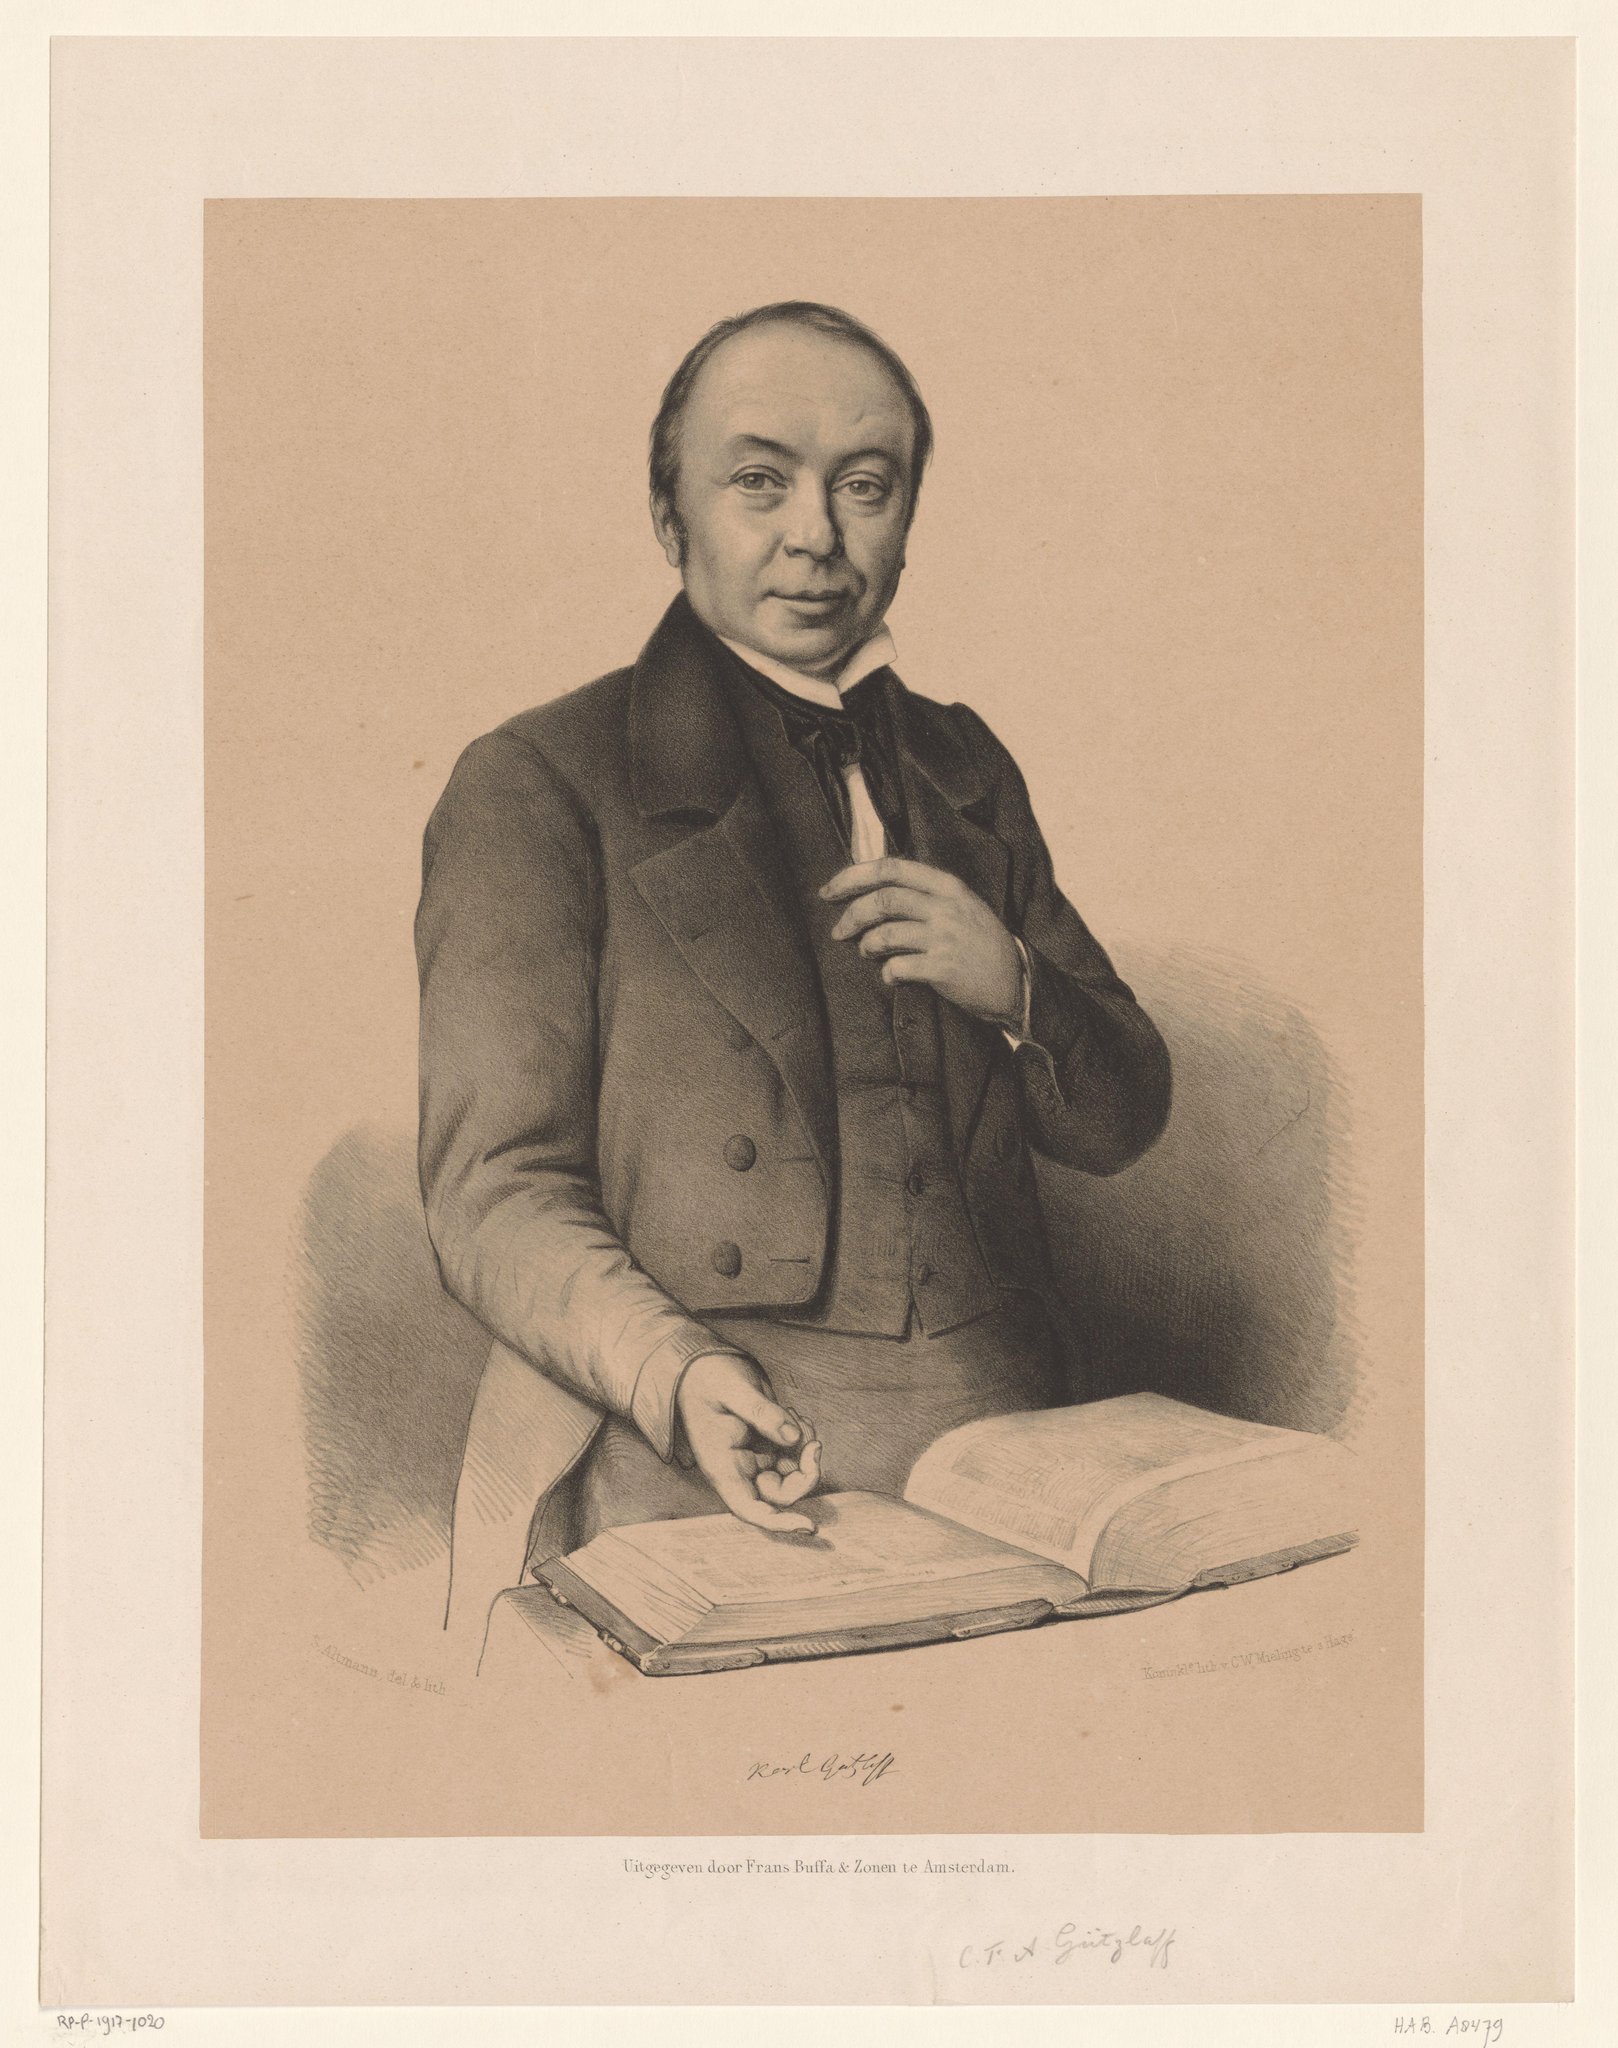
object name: print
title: Portret van Karl Friedrich August Gützlaff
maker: s. altmann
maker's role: painter, print maker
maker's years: 1822-1890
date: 1839-1847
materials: paper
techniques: lithograph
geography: the hague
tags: historical persons, book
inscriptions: collector's mark: Lugt 2228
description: Onder het portret een facsimile van de handtekening van de geportretteerde.